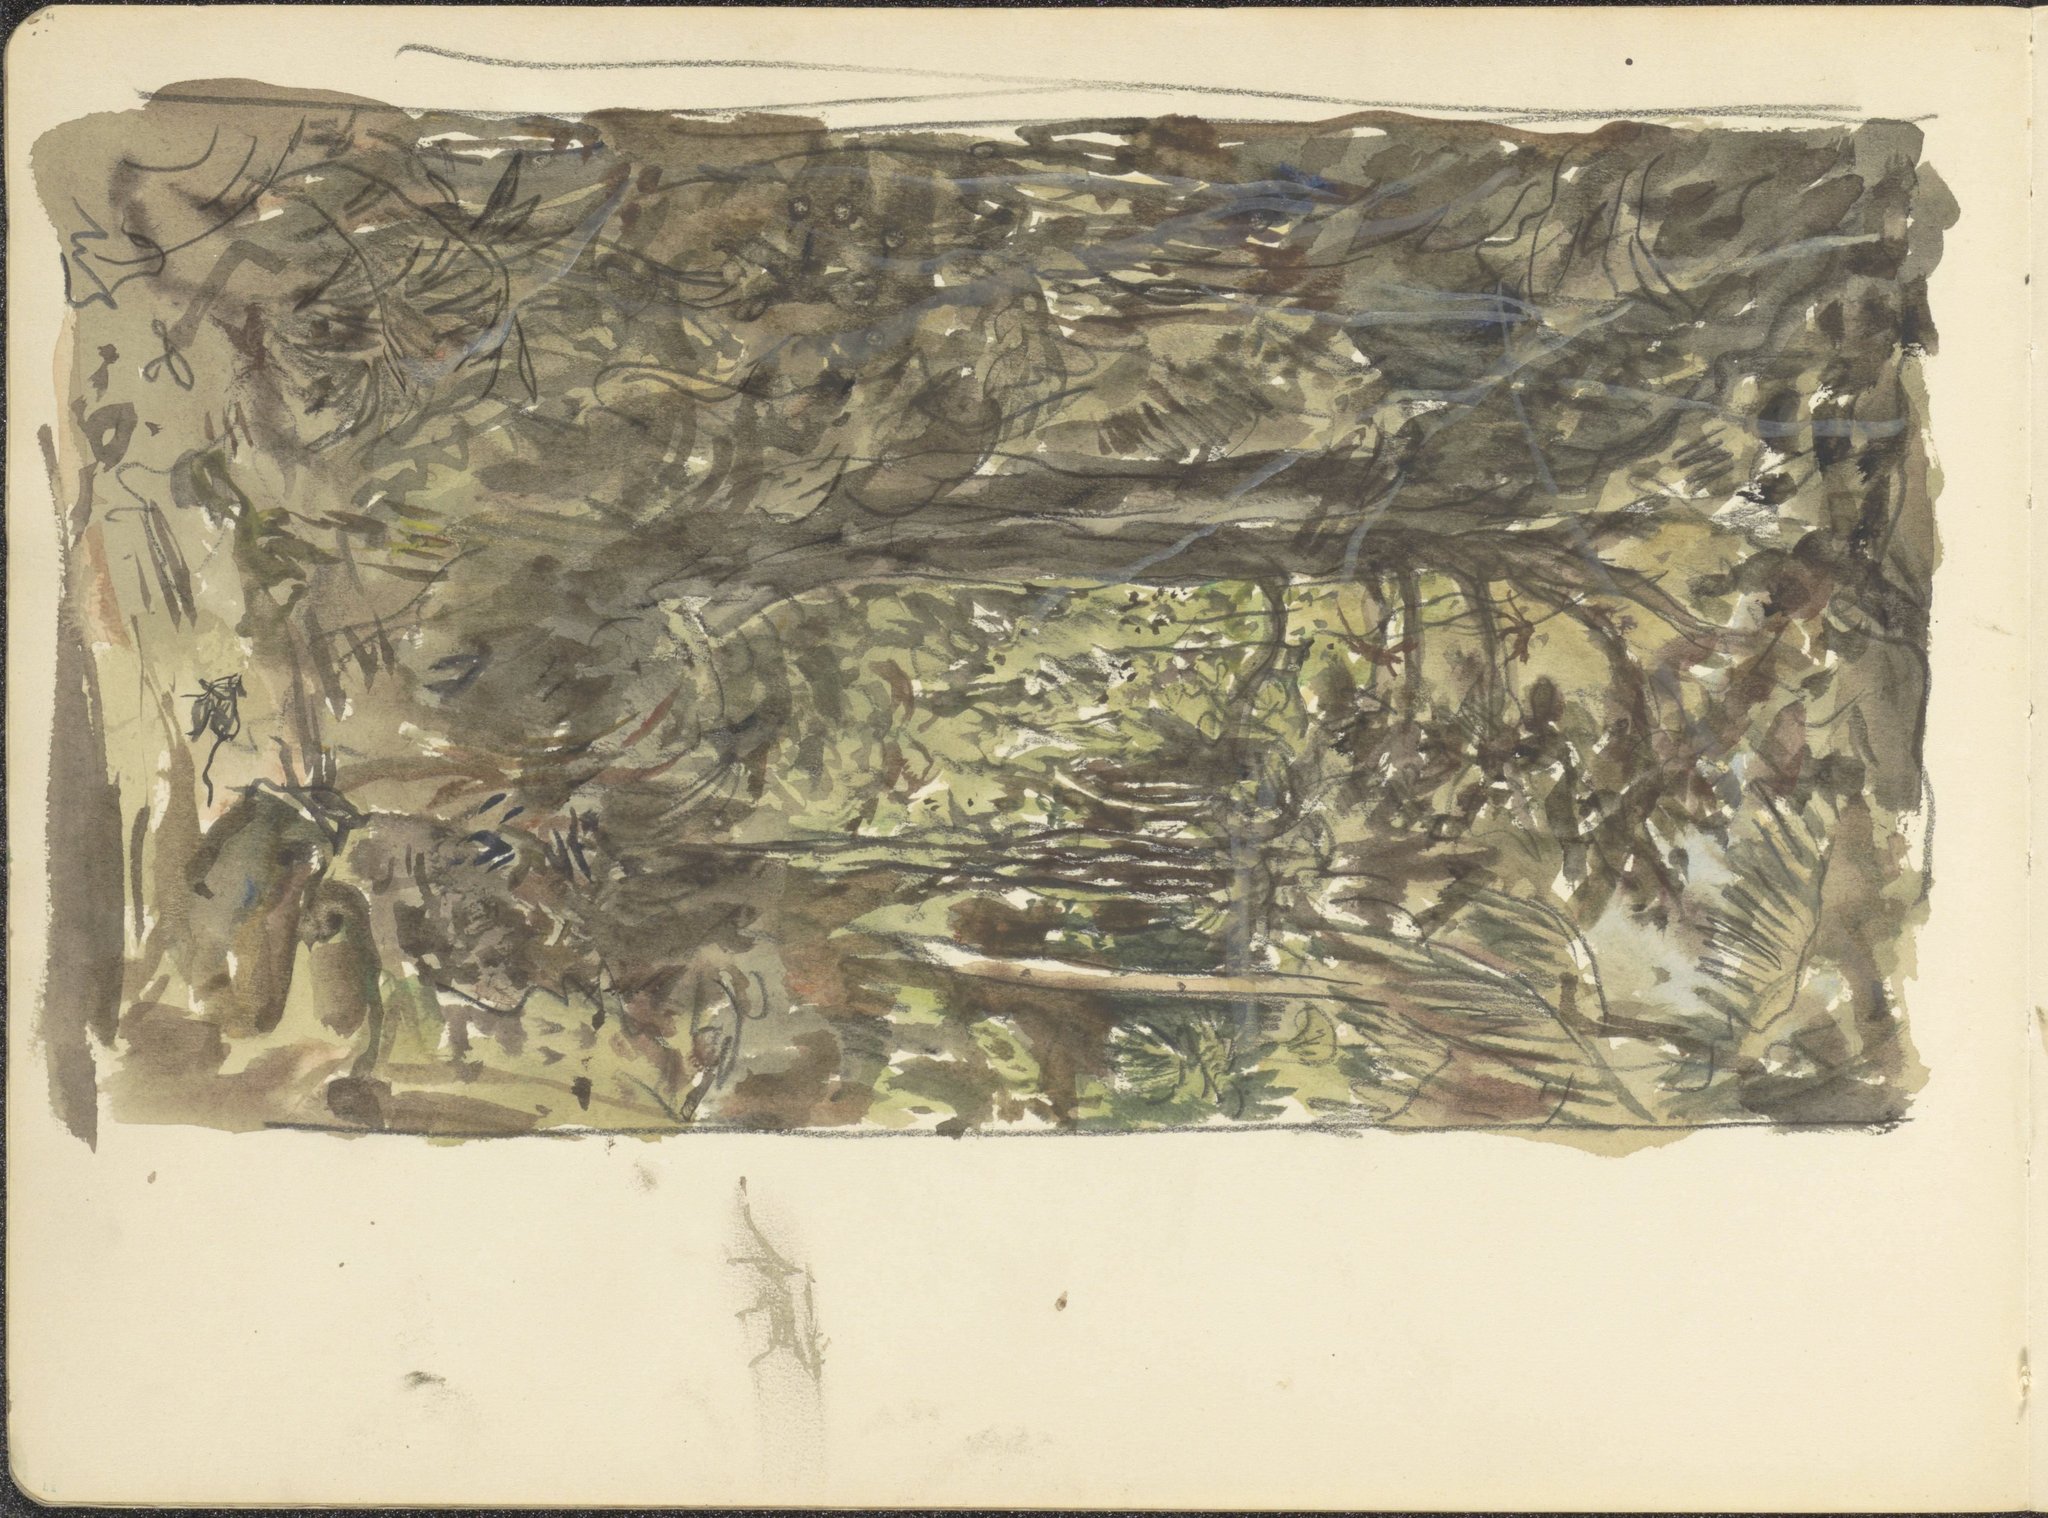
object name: sketchbook leaf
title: Oerwoud van Ceylon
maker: marius bauer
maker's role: draughtsman, print maker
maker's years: 1867-1932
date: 1924-1925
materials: chalk, paper, watercolor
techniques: brush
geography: sri lanka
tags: jungle, sri lanka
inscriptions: monogram: ‘MB’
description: Pagina 4 uit een schetsboek met 20 bladen.